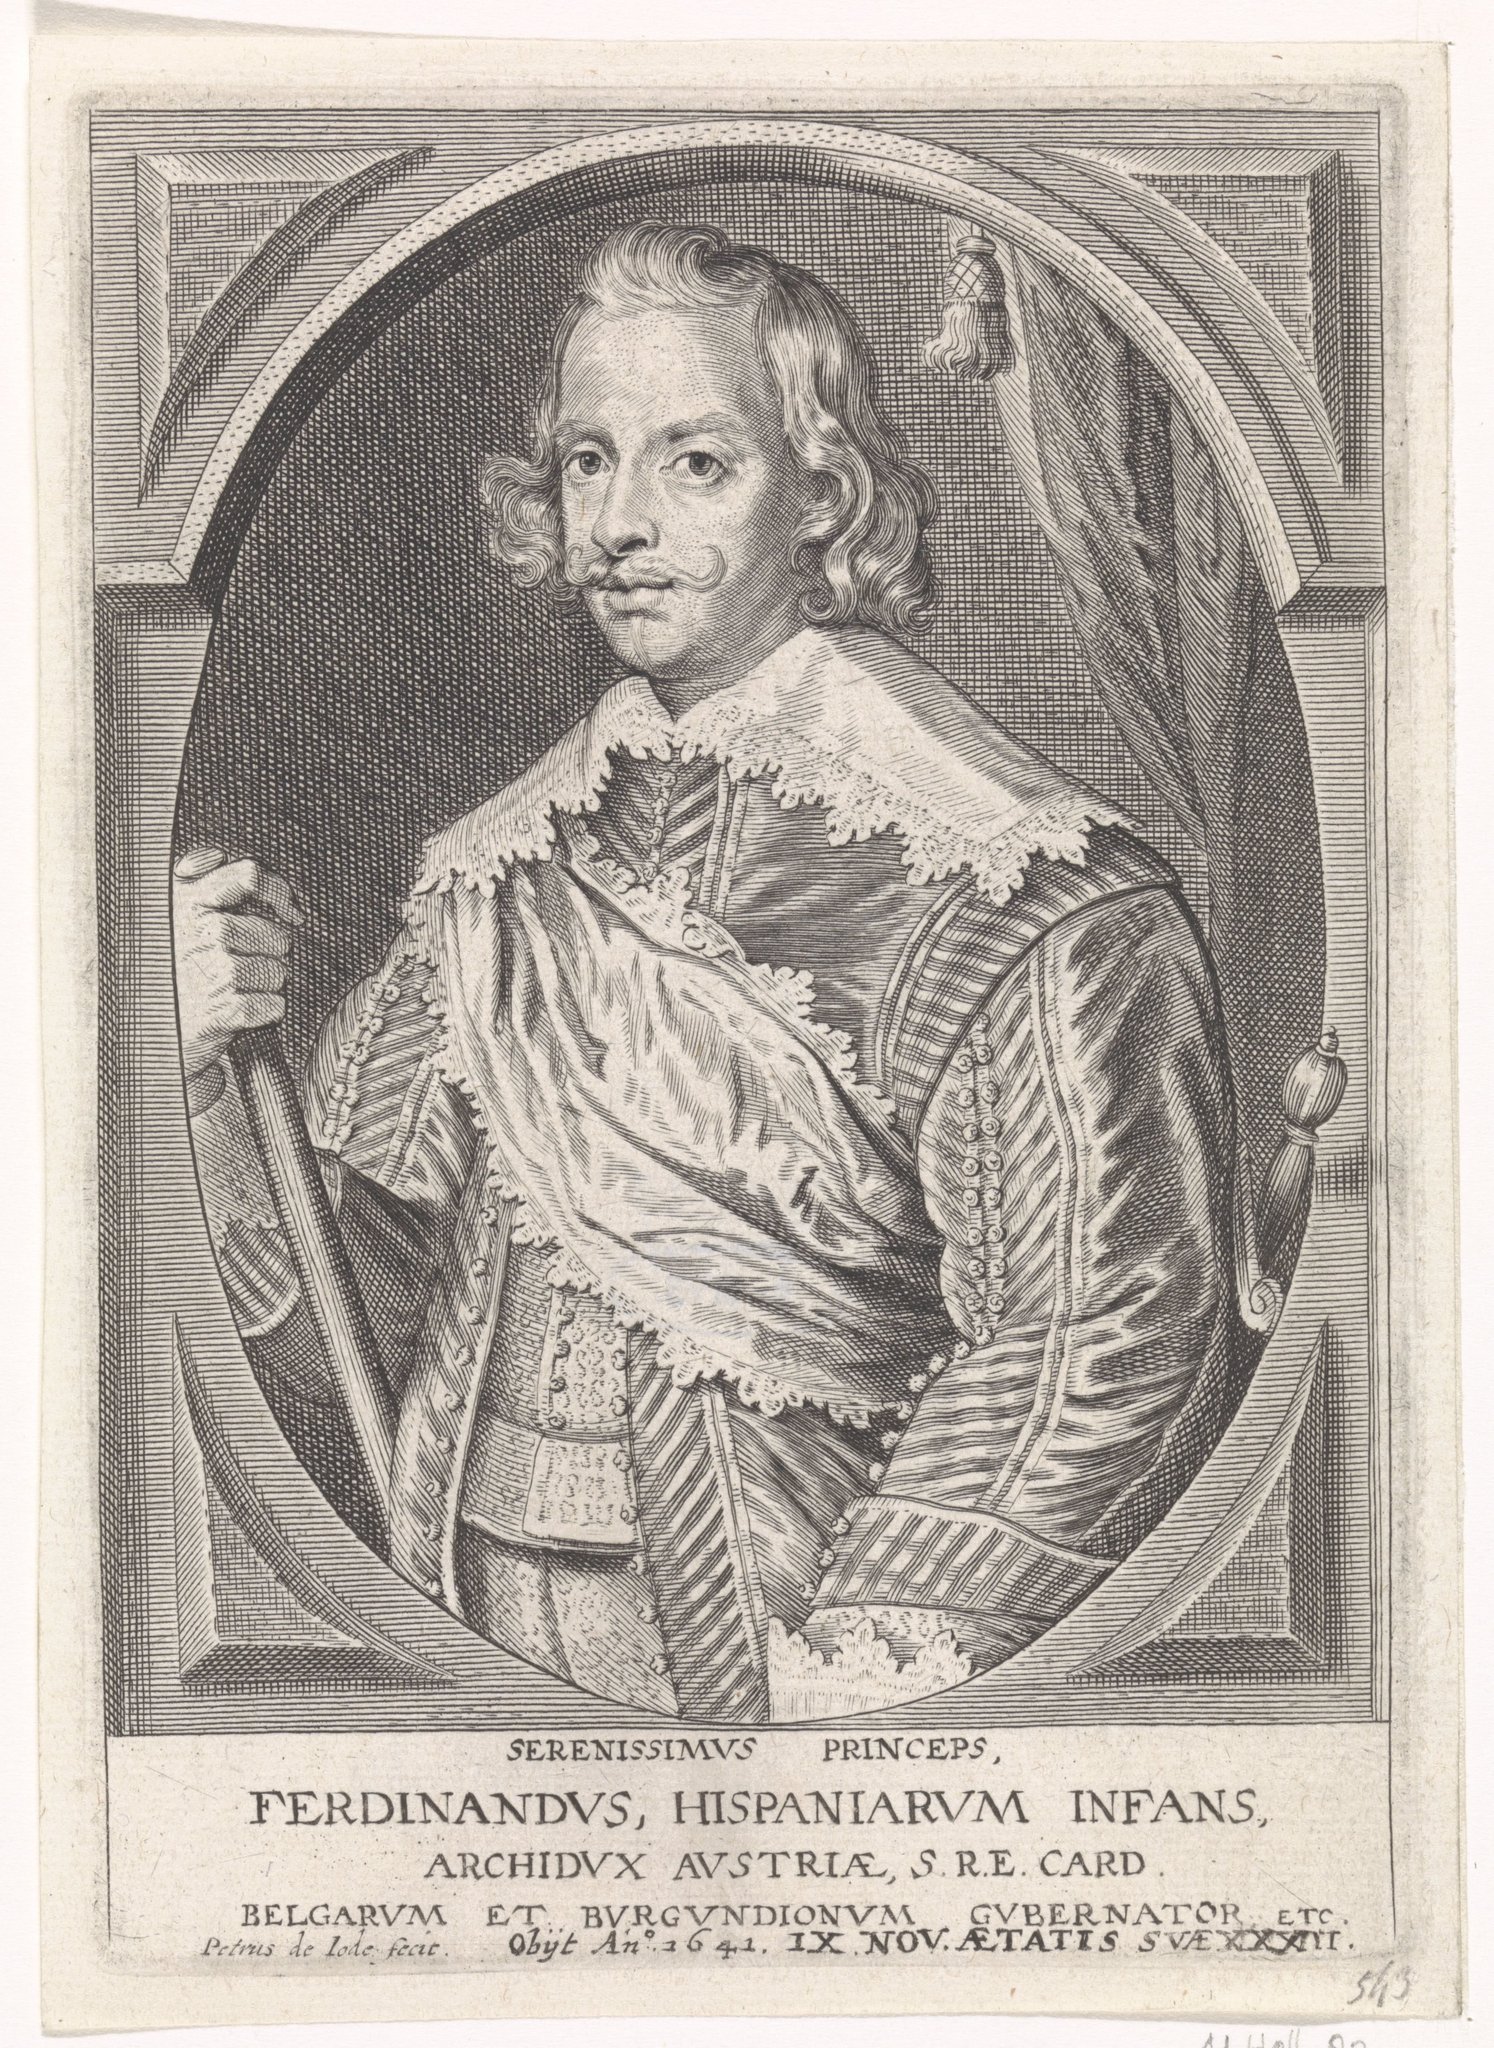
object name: print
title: Theater van bisschoppen, keizers, koningen, hertogen, prinsen, enz.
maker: pieter de jode (ii)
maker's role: draughtsman, print maker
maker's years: 1606-1674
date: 1641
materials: paper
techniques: engraving, etching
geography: england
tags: brussels, landvoogd der zuidelijke nederlanden ferdinand van oostenrijk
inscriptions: collector's mark: Lugt 2228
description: Portret van Ferdinand van Oostenrijk, op 32-jarige leeftijd. In zijn rechterhand houdt hij een commandostaf. Het portret is gevat in een ovale omlijsting. In de marge een onderschrift in het Latijn.